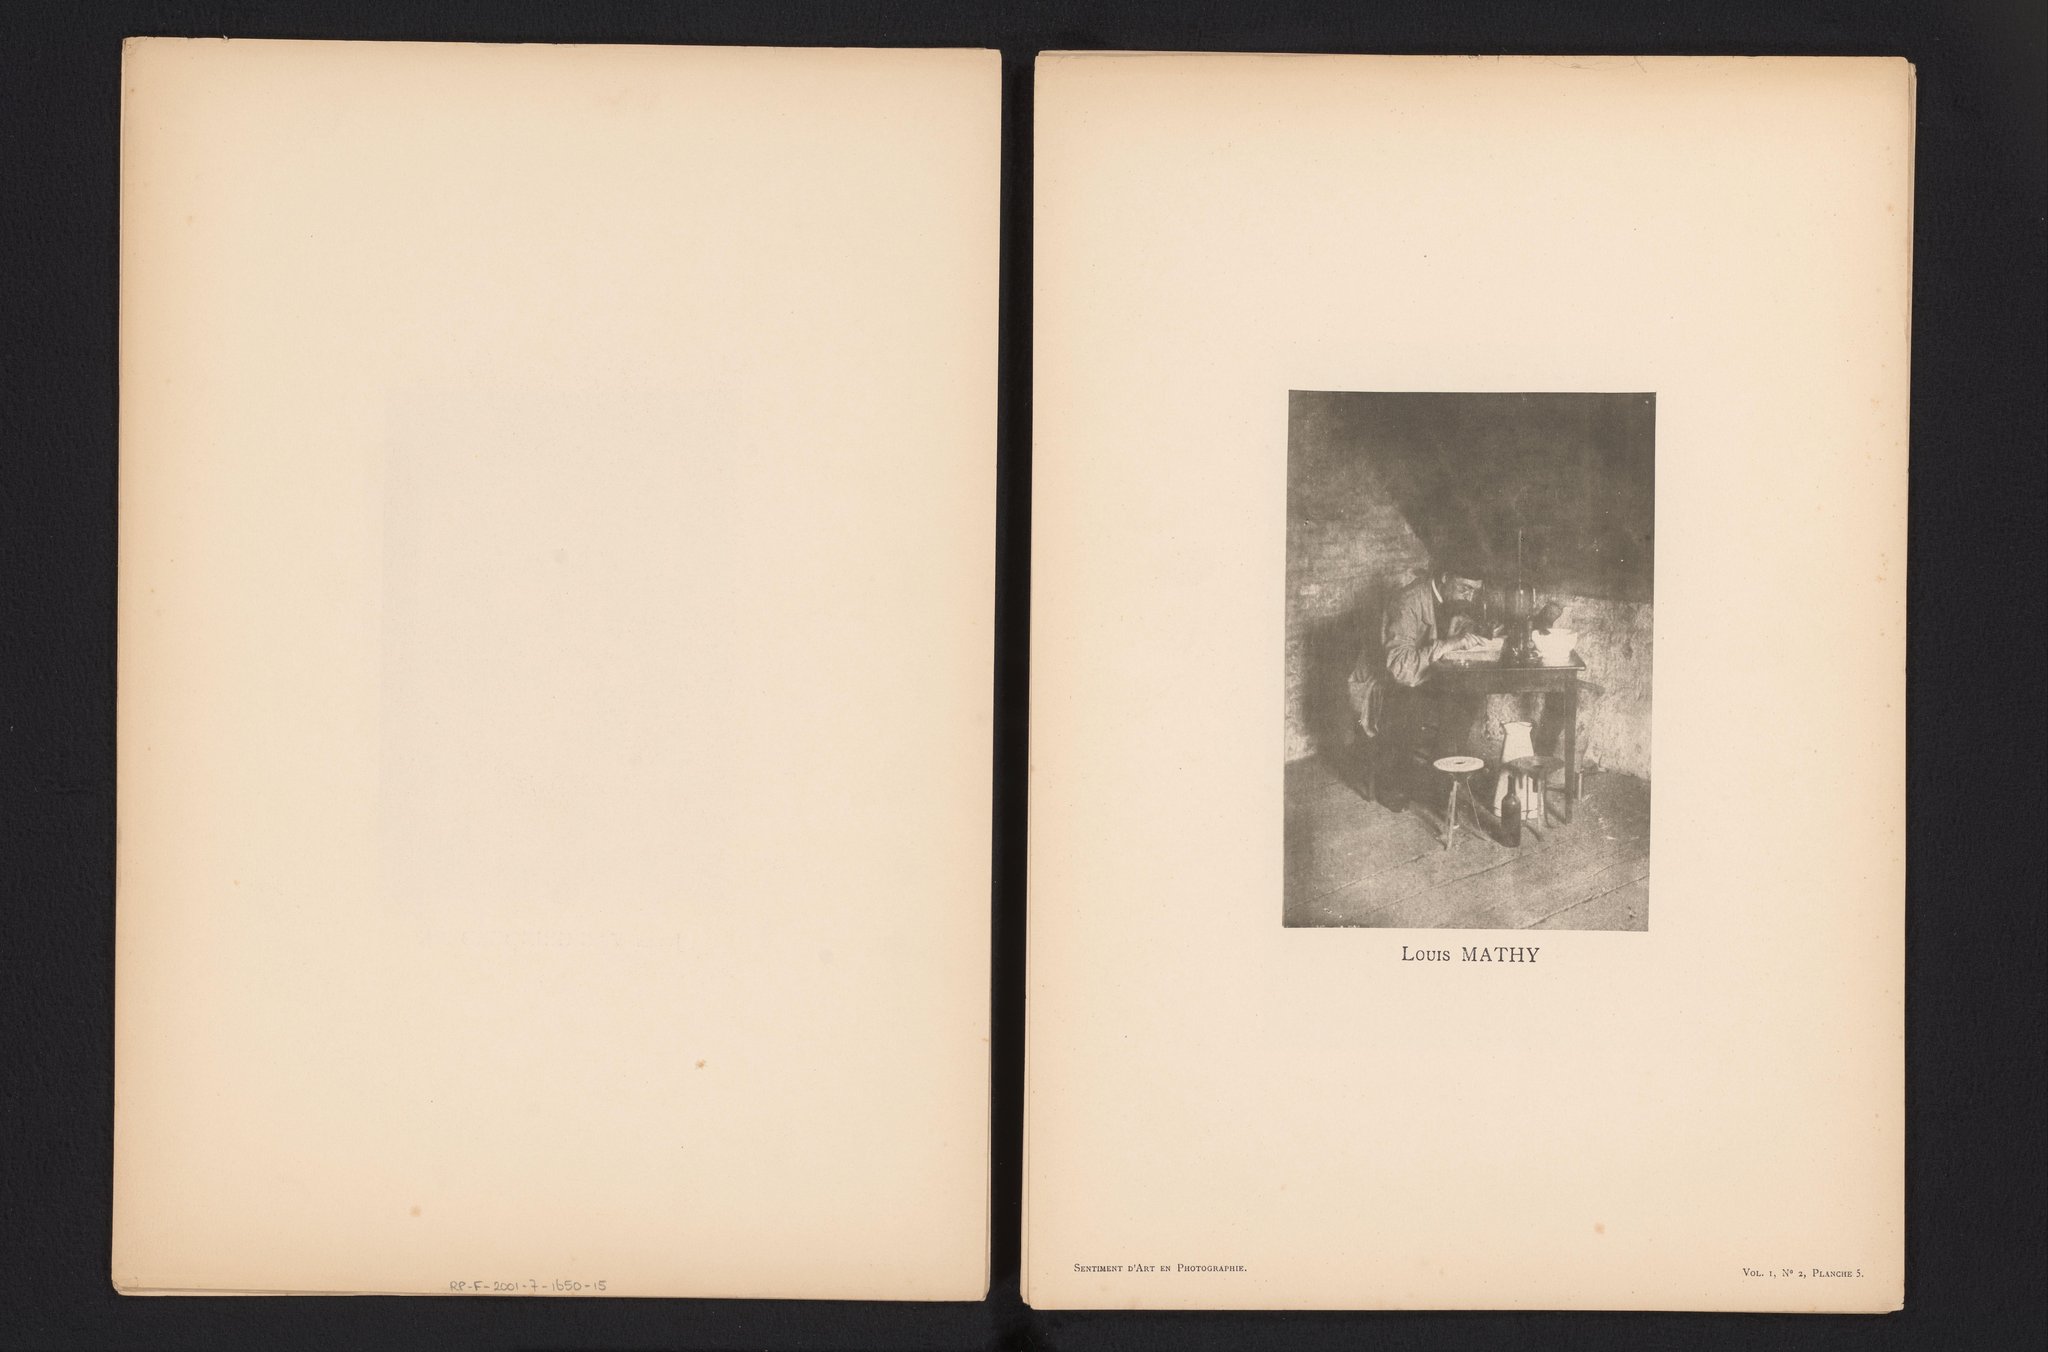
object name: photomechanical print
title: Man zit aan tafel te lezen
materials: paper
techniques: photograph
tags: reading, adult man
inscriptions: number: ‘Vol. 1, No 2, Planche 5.’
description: Deze prent maakt deel uit van 8 omslagen met 22 tekstbladen en 89 prenten op losse bladen in en tussen de omslagen.